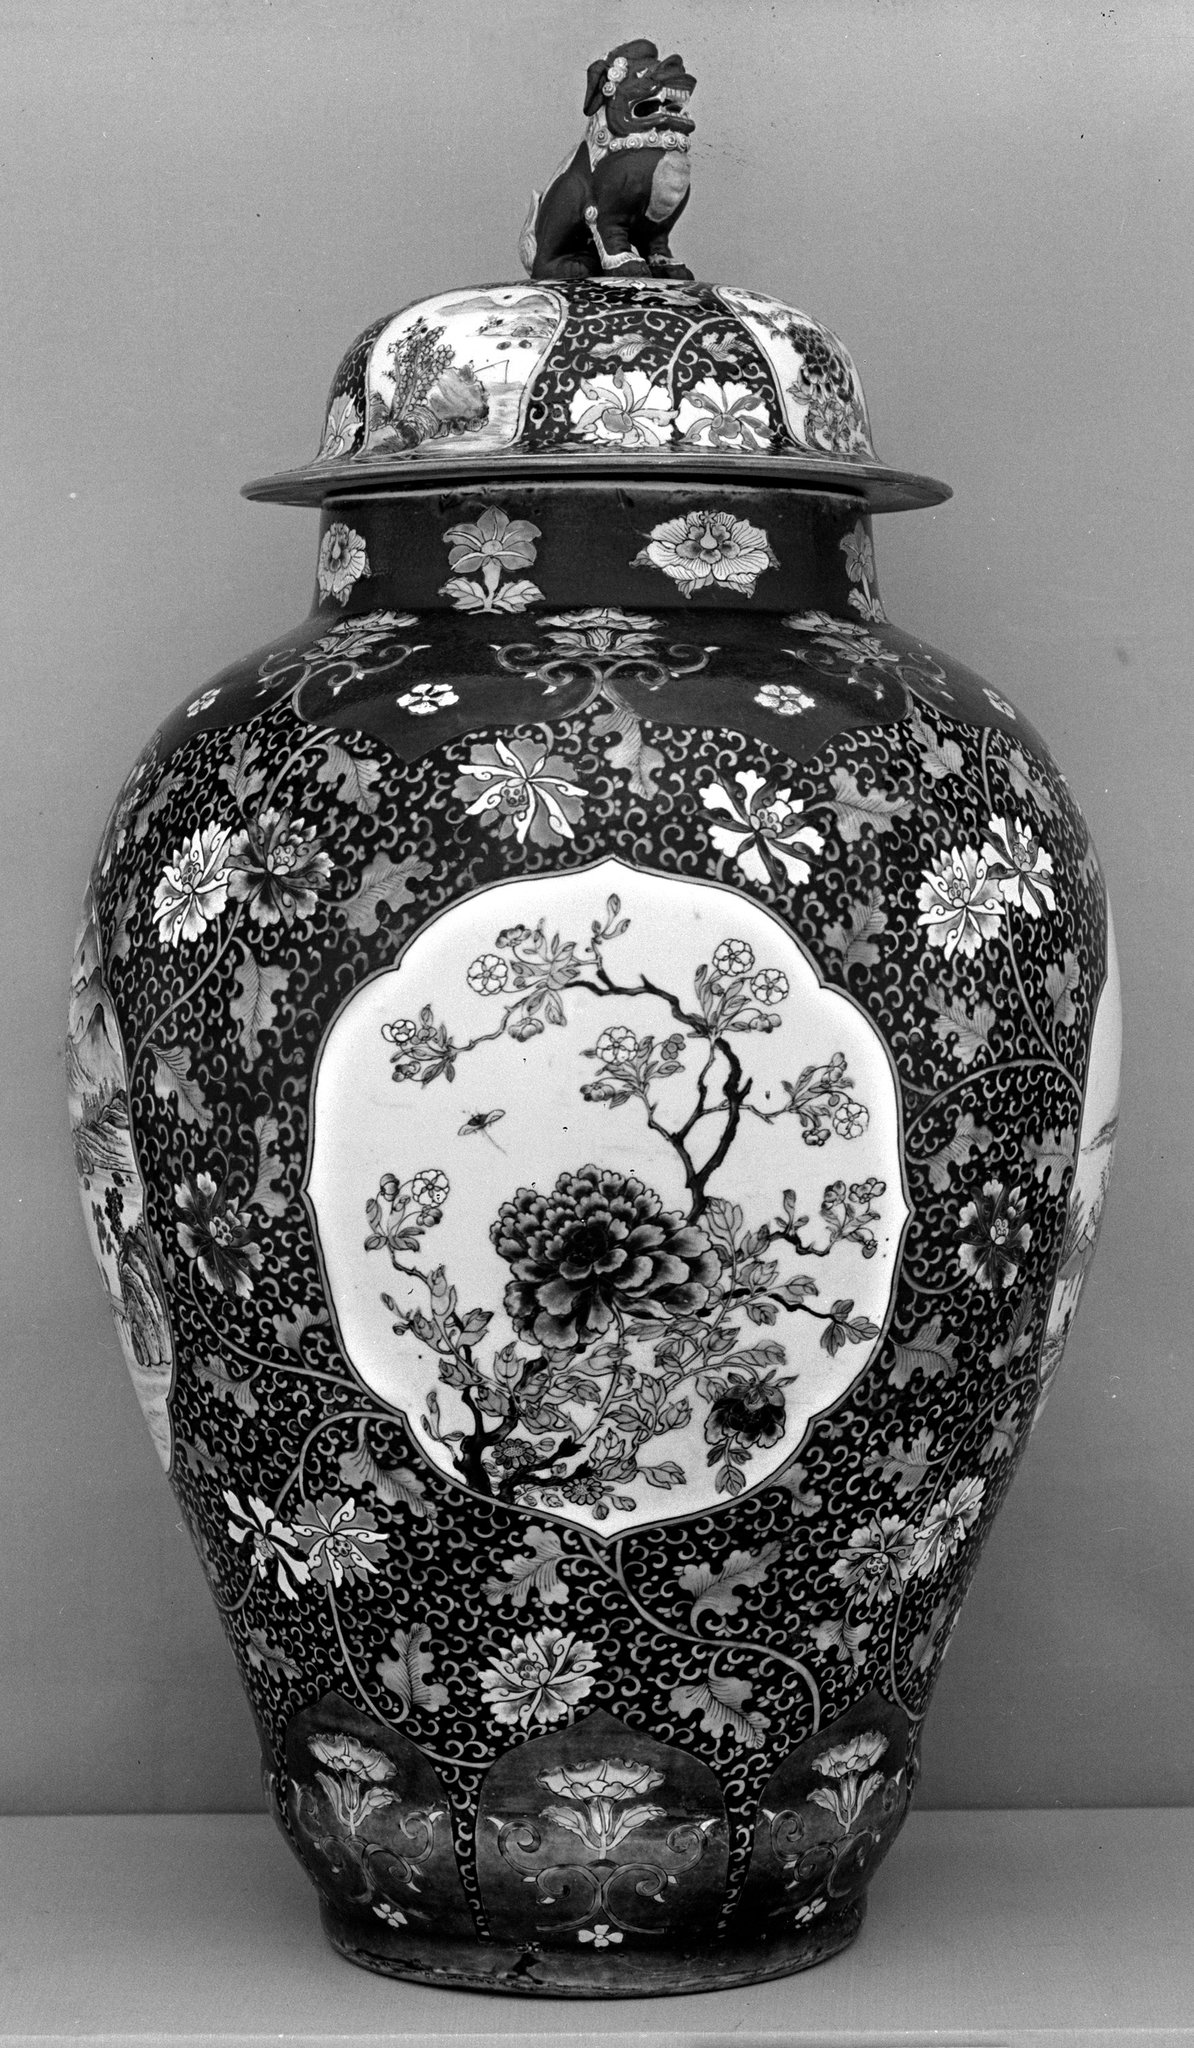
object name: covered jar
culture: chinese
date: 1736-1795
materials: porcelain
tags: flowers